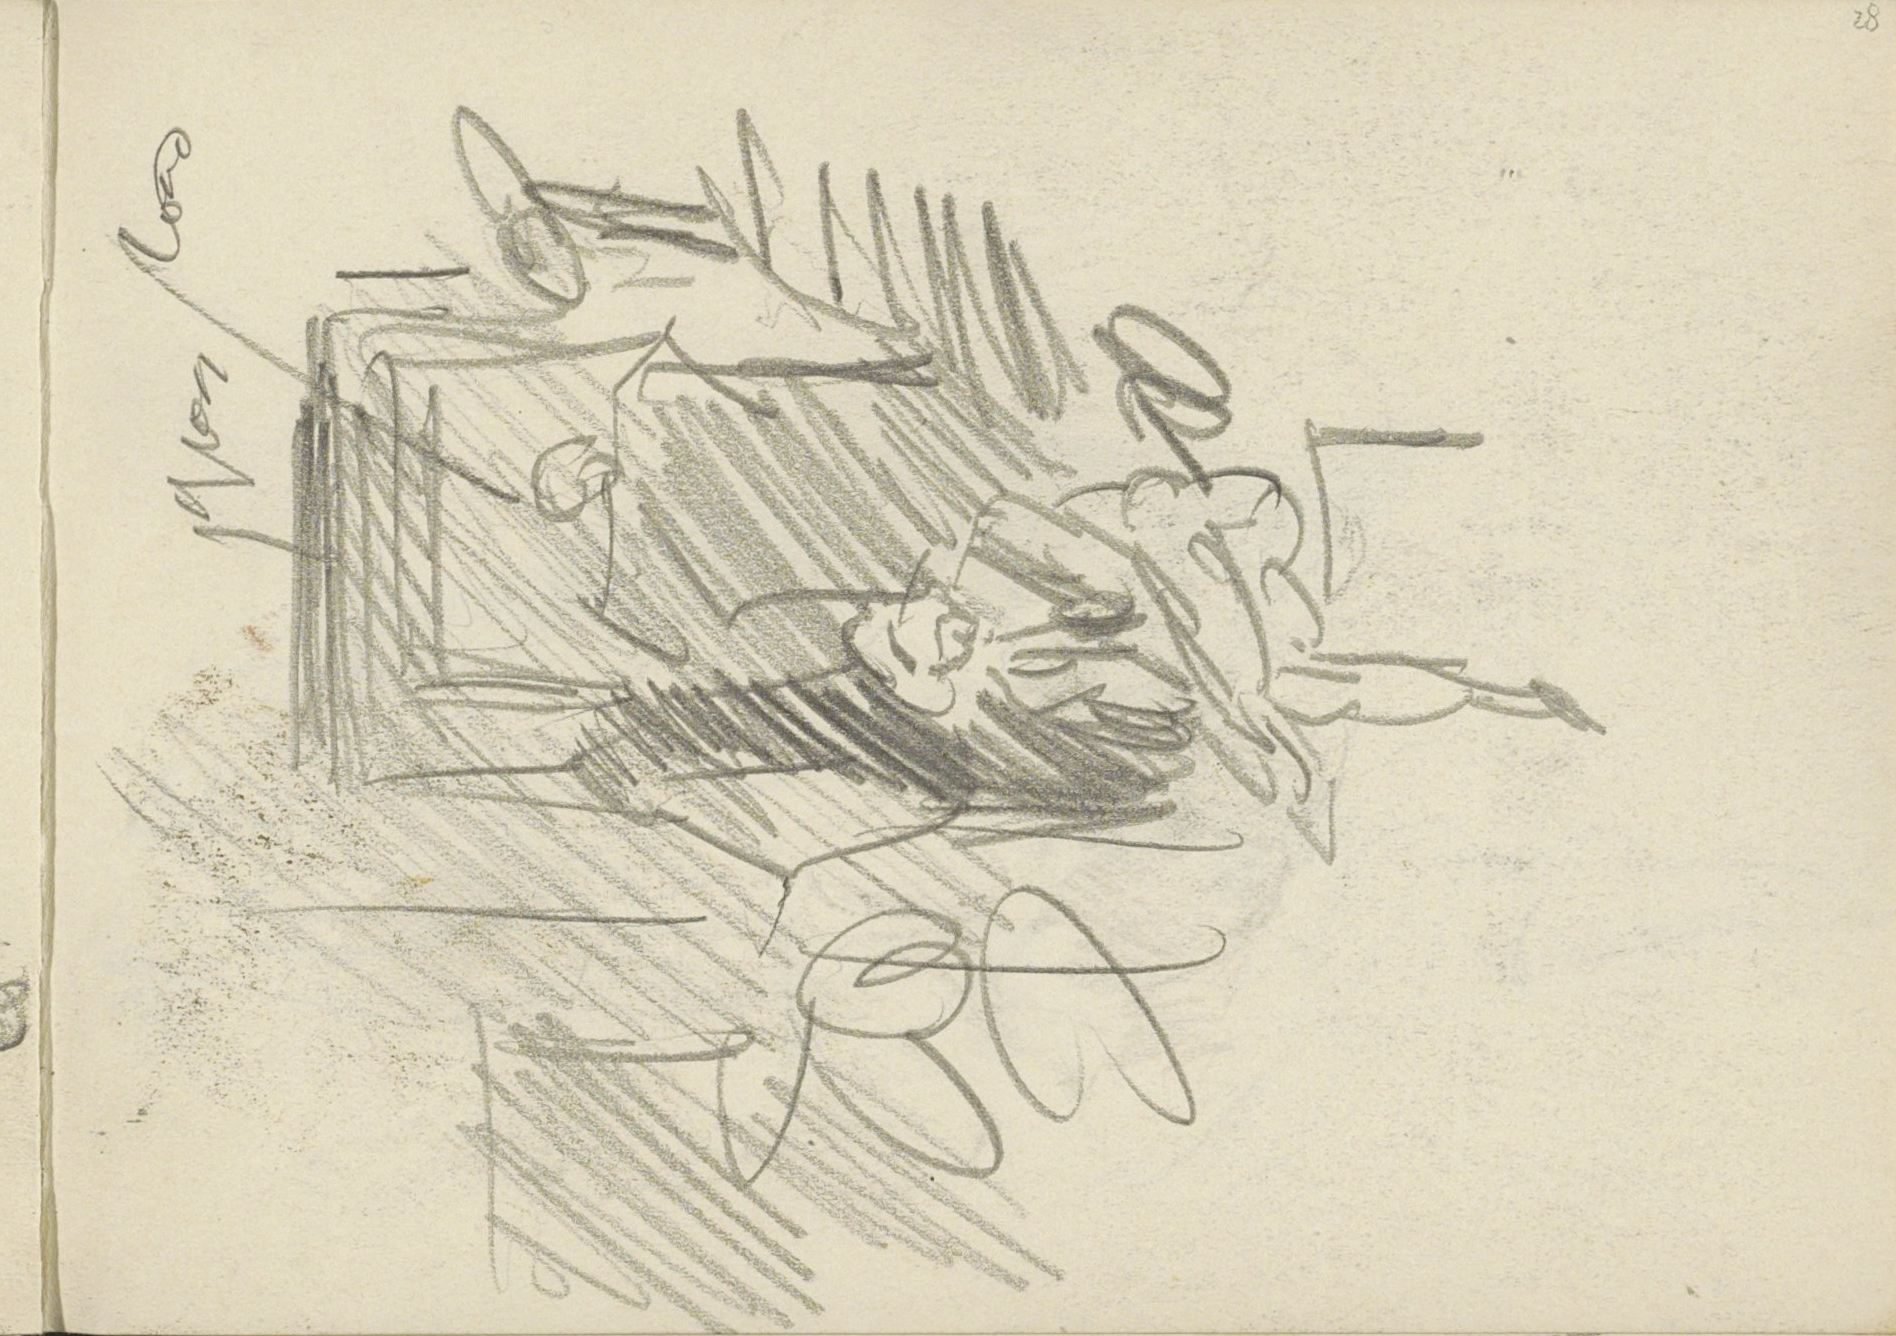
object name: sketchbook leaf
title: Zittende figuur, mogelijk een artiest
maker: isaac israels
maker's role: draughtsman, painter, print maker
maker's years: 1865-1934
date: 1930-1934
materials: paper, pencil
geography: the hague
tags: dressing-room ~ stage, performer, artiste (non-work situations), the (nude) human figure; 'corpo humano' (ripa) (+ sitting)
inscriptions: : ‘groen / rood’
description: Mogelijk in een kleedkamer. Pagina 28 uit schetsboek XXXVIII met 45 pagina's.